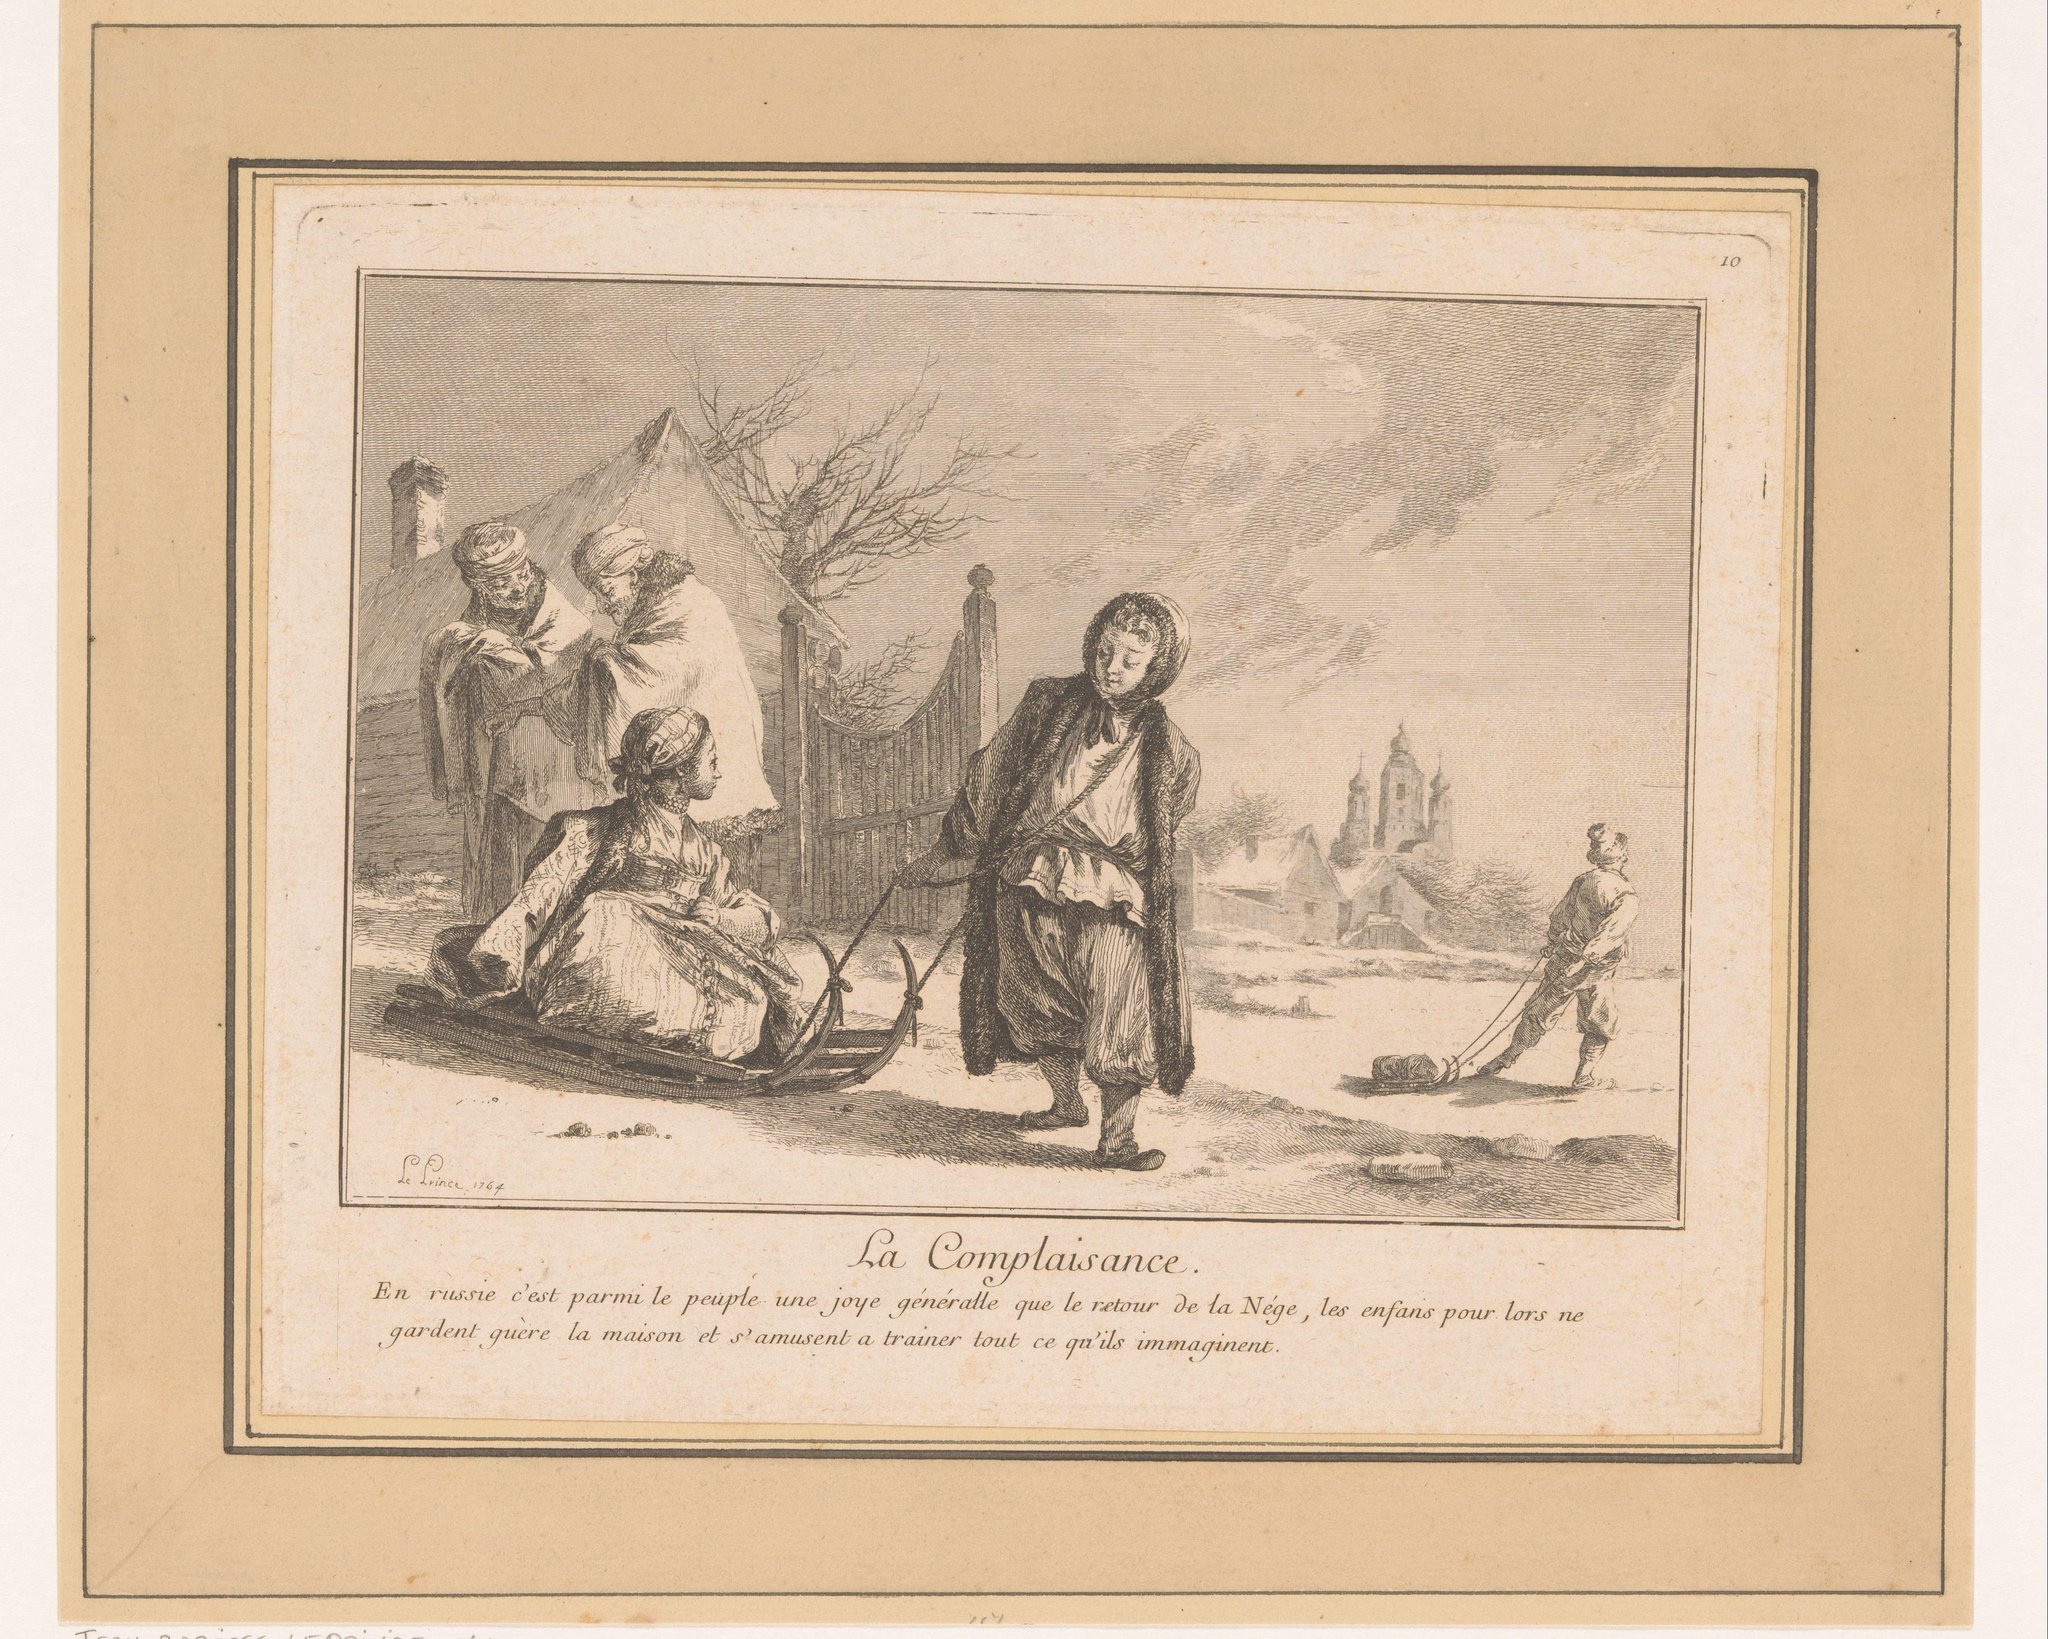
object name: print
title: La Complaisance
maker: jean baptist leprince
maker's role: draughtsman, print maker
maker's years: 1734-1781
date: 1764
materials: paper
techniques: etching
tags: skates (winter sports), sledge, sleigh (winter sports)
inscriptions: date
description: In een winterlandschap trekt een vrouw een andere vrouw voort op een slee. Links lopen een oude man en een oude vrouw voor een huis. Rechts loopt een man op het ijs.